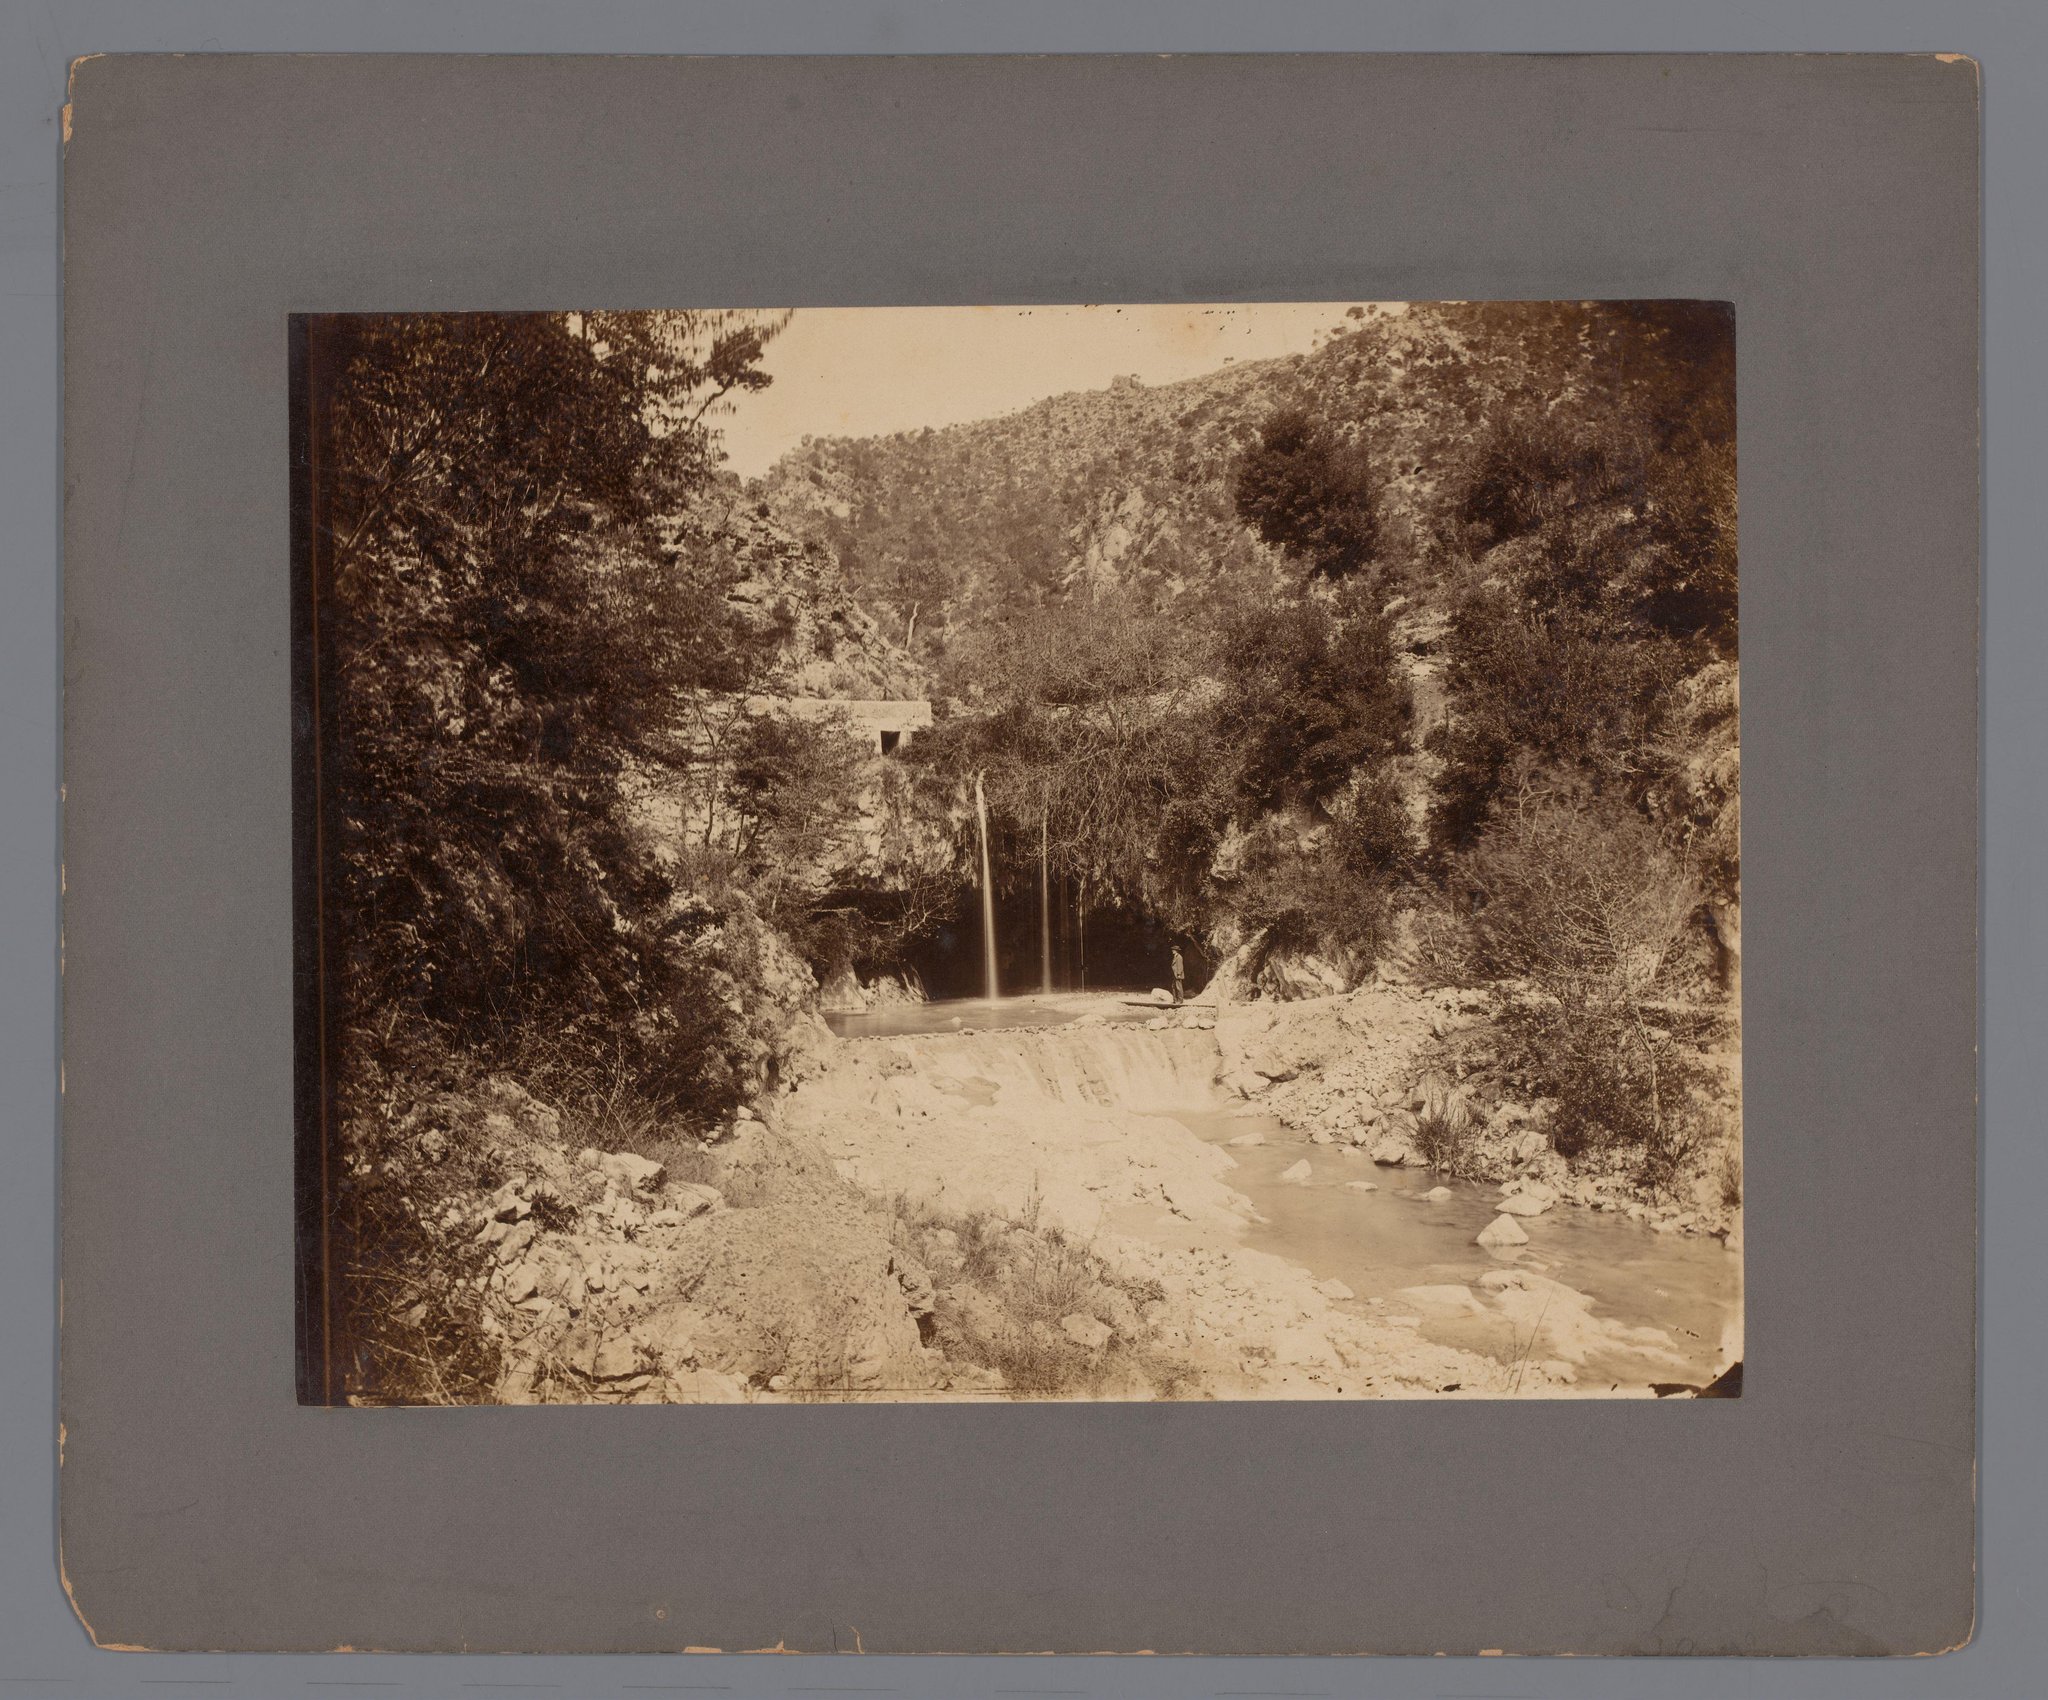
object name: photograph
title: Landschap met beek en waterval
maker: Anonymous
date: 1880-1900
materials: cardboard, paper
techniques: albumen print